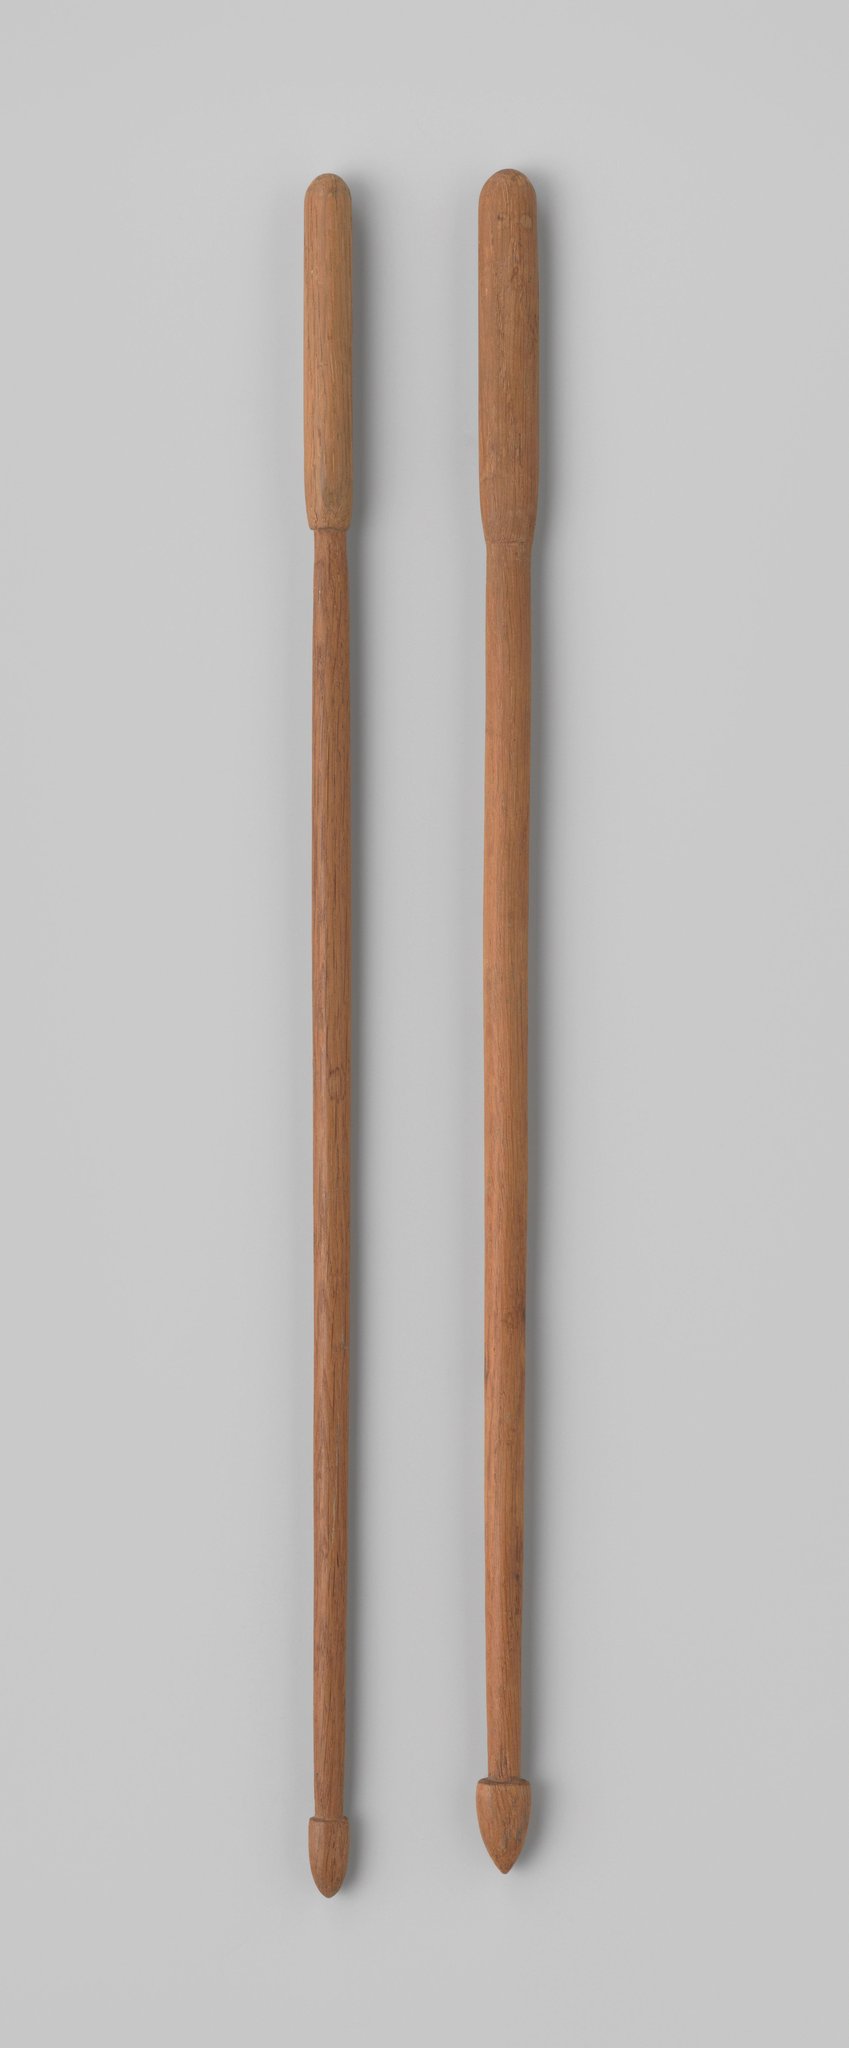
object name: percussion instrument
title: Drumsticks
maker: Anonymous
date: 1900-2000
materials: wood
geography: netherlands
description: - Replica tromstok van een 17e of 18e eeuwse tromstok. - Replica tromstok van een 17e of 18e eeuwse tromstok, Nederland, 20e eeuw.